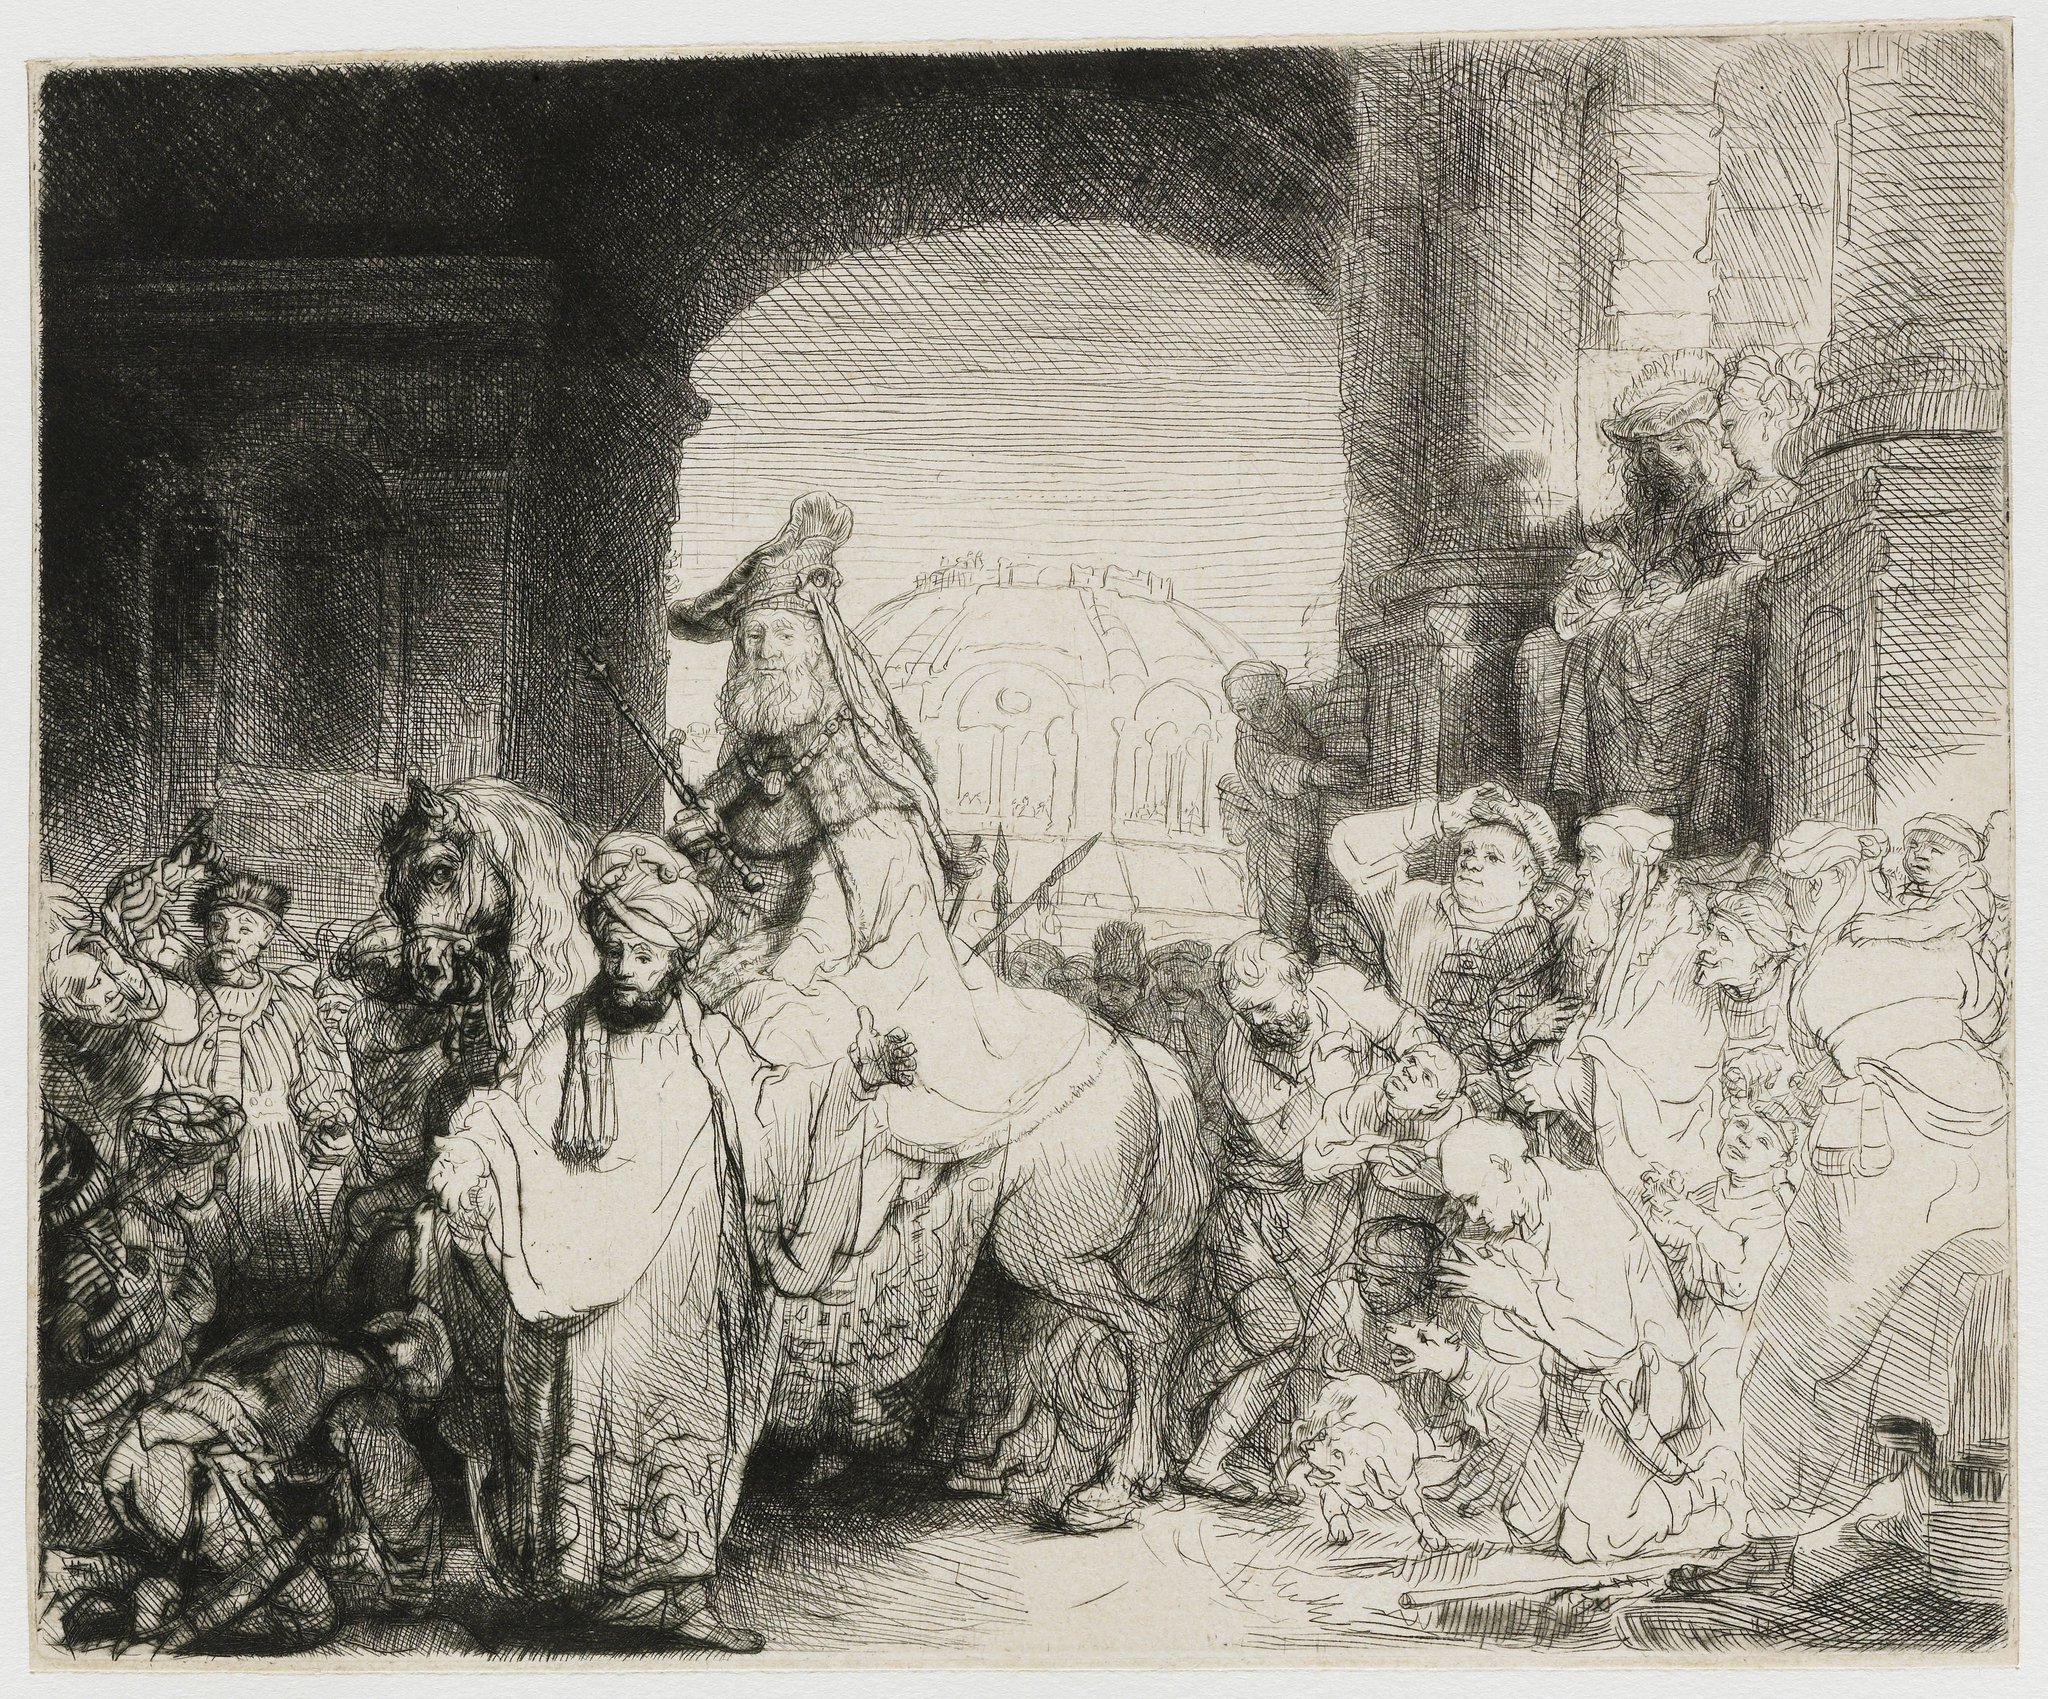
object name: print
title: The triumph of Mordecai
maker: rembrandt van rijn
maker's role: draughtsman, painter, print maker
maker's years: 1606-1669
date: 1641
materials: paper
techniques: drypoint, etching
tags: mordecai's triumph: mordecai, mounted on the king's horse, is led through the city by haman (esther and ahasuerus may be looking on from the palace)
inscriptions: mark: Lugt 2228, mark: Lugt 1938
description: Rembrandt achieved the velvety black tones in this print with drypoint, a technique he had previously never used so extensively. We see the Jewish Mordecai seated on the horse of the Persian king Ahasuerus and garbed in the monarch’s clothing. This was his reward for services rendered. He is accompanied by Ahasuerus’s vizier Haman, who actually wants to kill all the Jews.